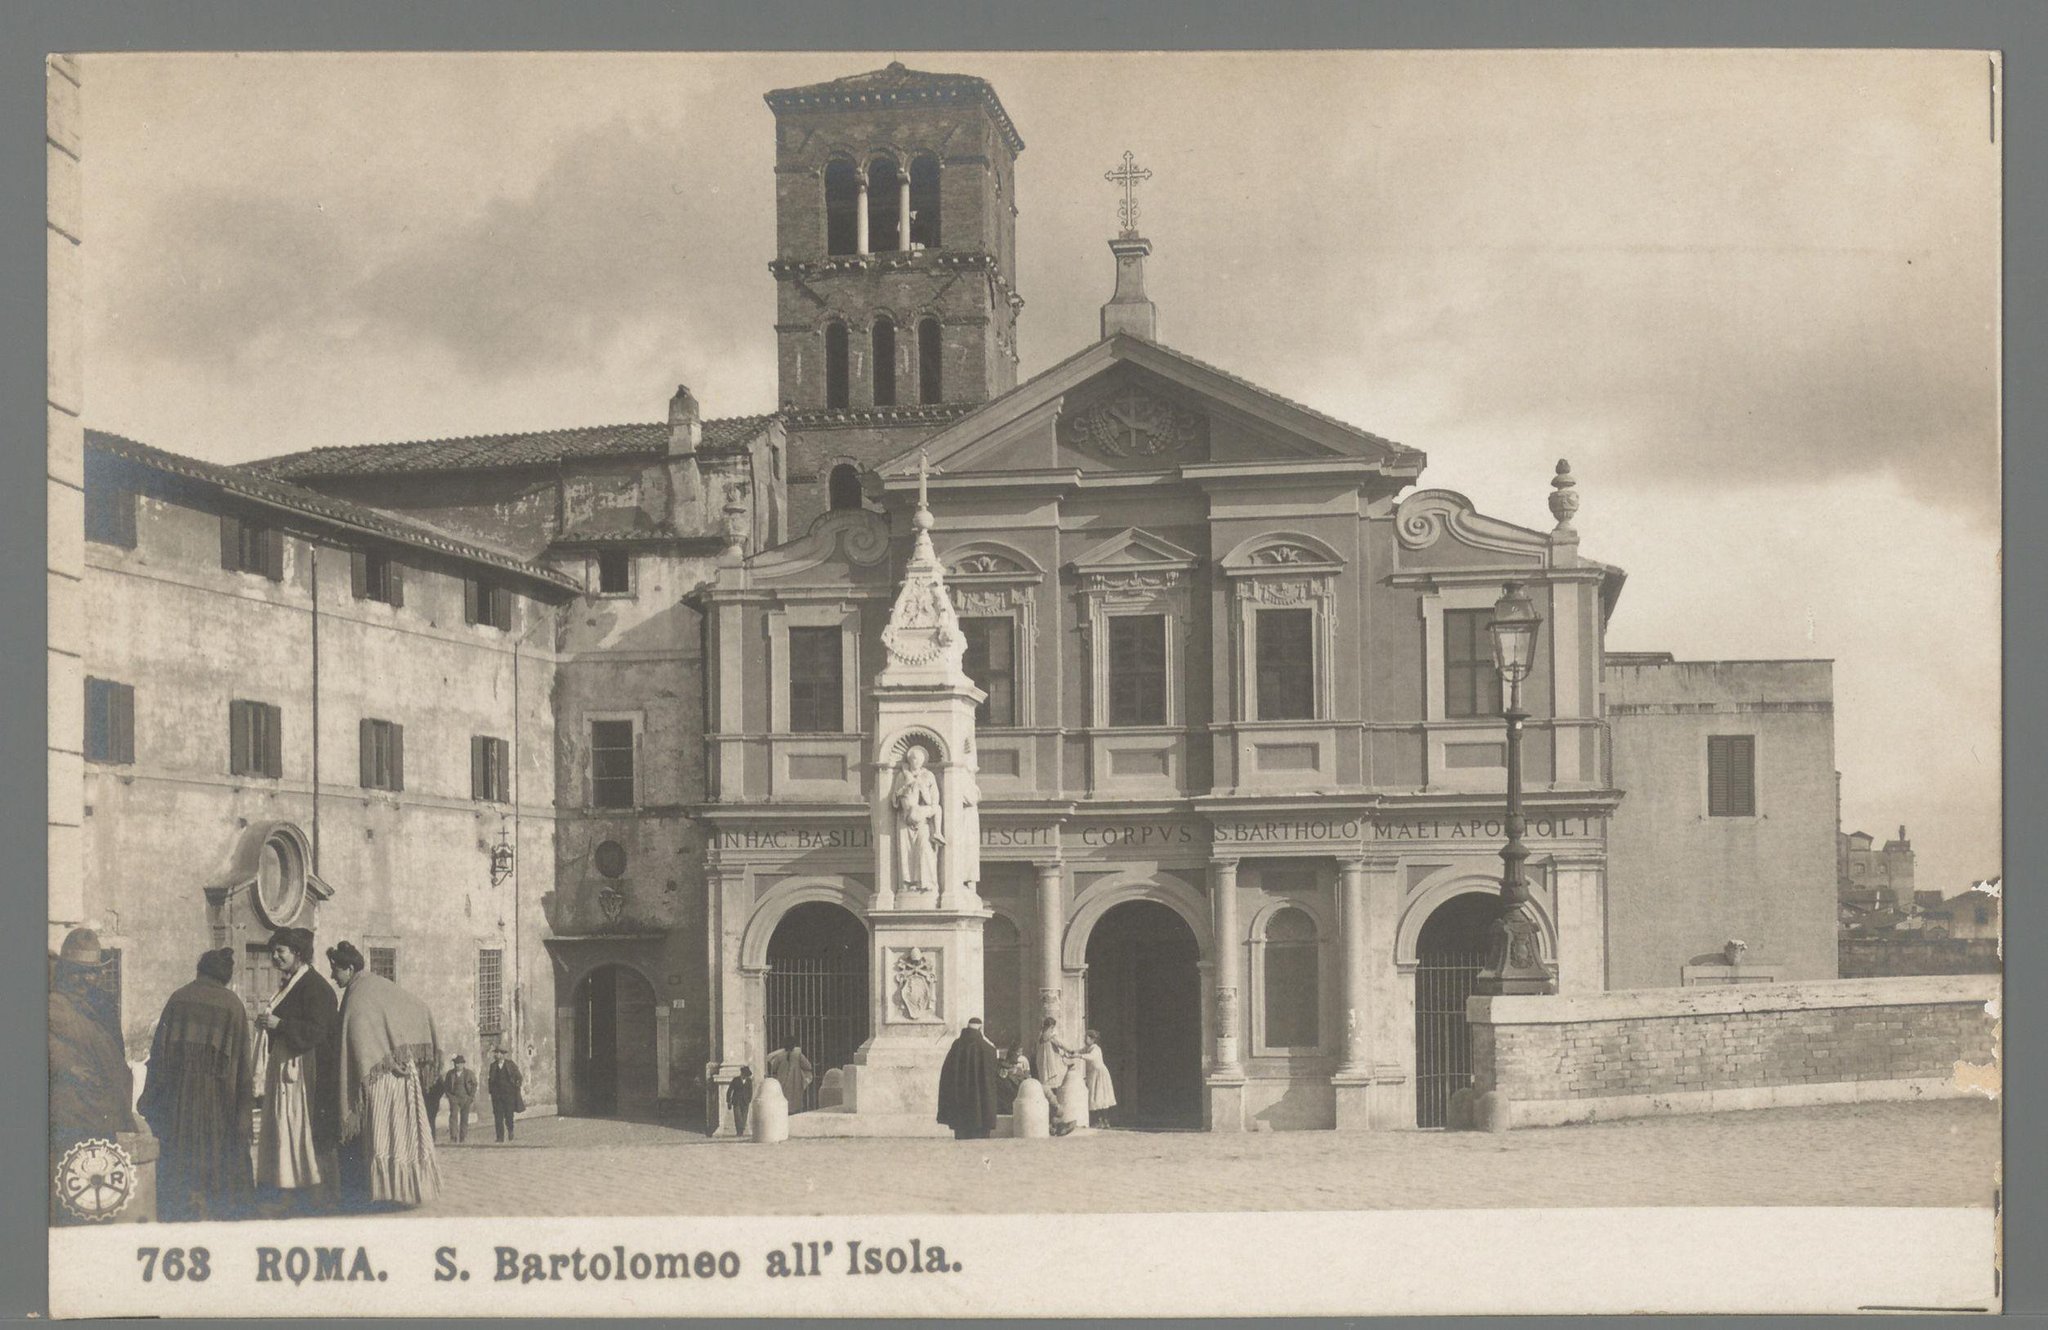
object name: photograph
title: Roma. S. Bartolomeo all'Isola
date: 1906-1930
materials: photographic support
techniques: photography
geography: italy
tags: church (exterior), square, place, circus, etc. (+ city(-scape) with figures, staffage)